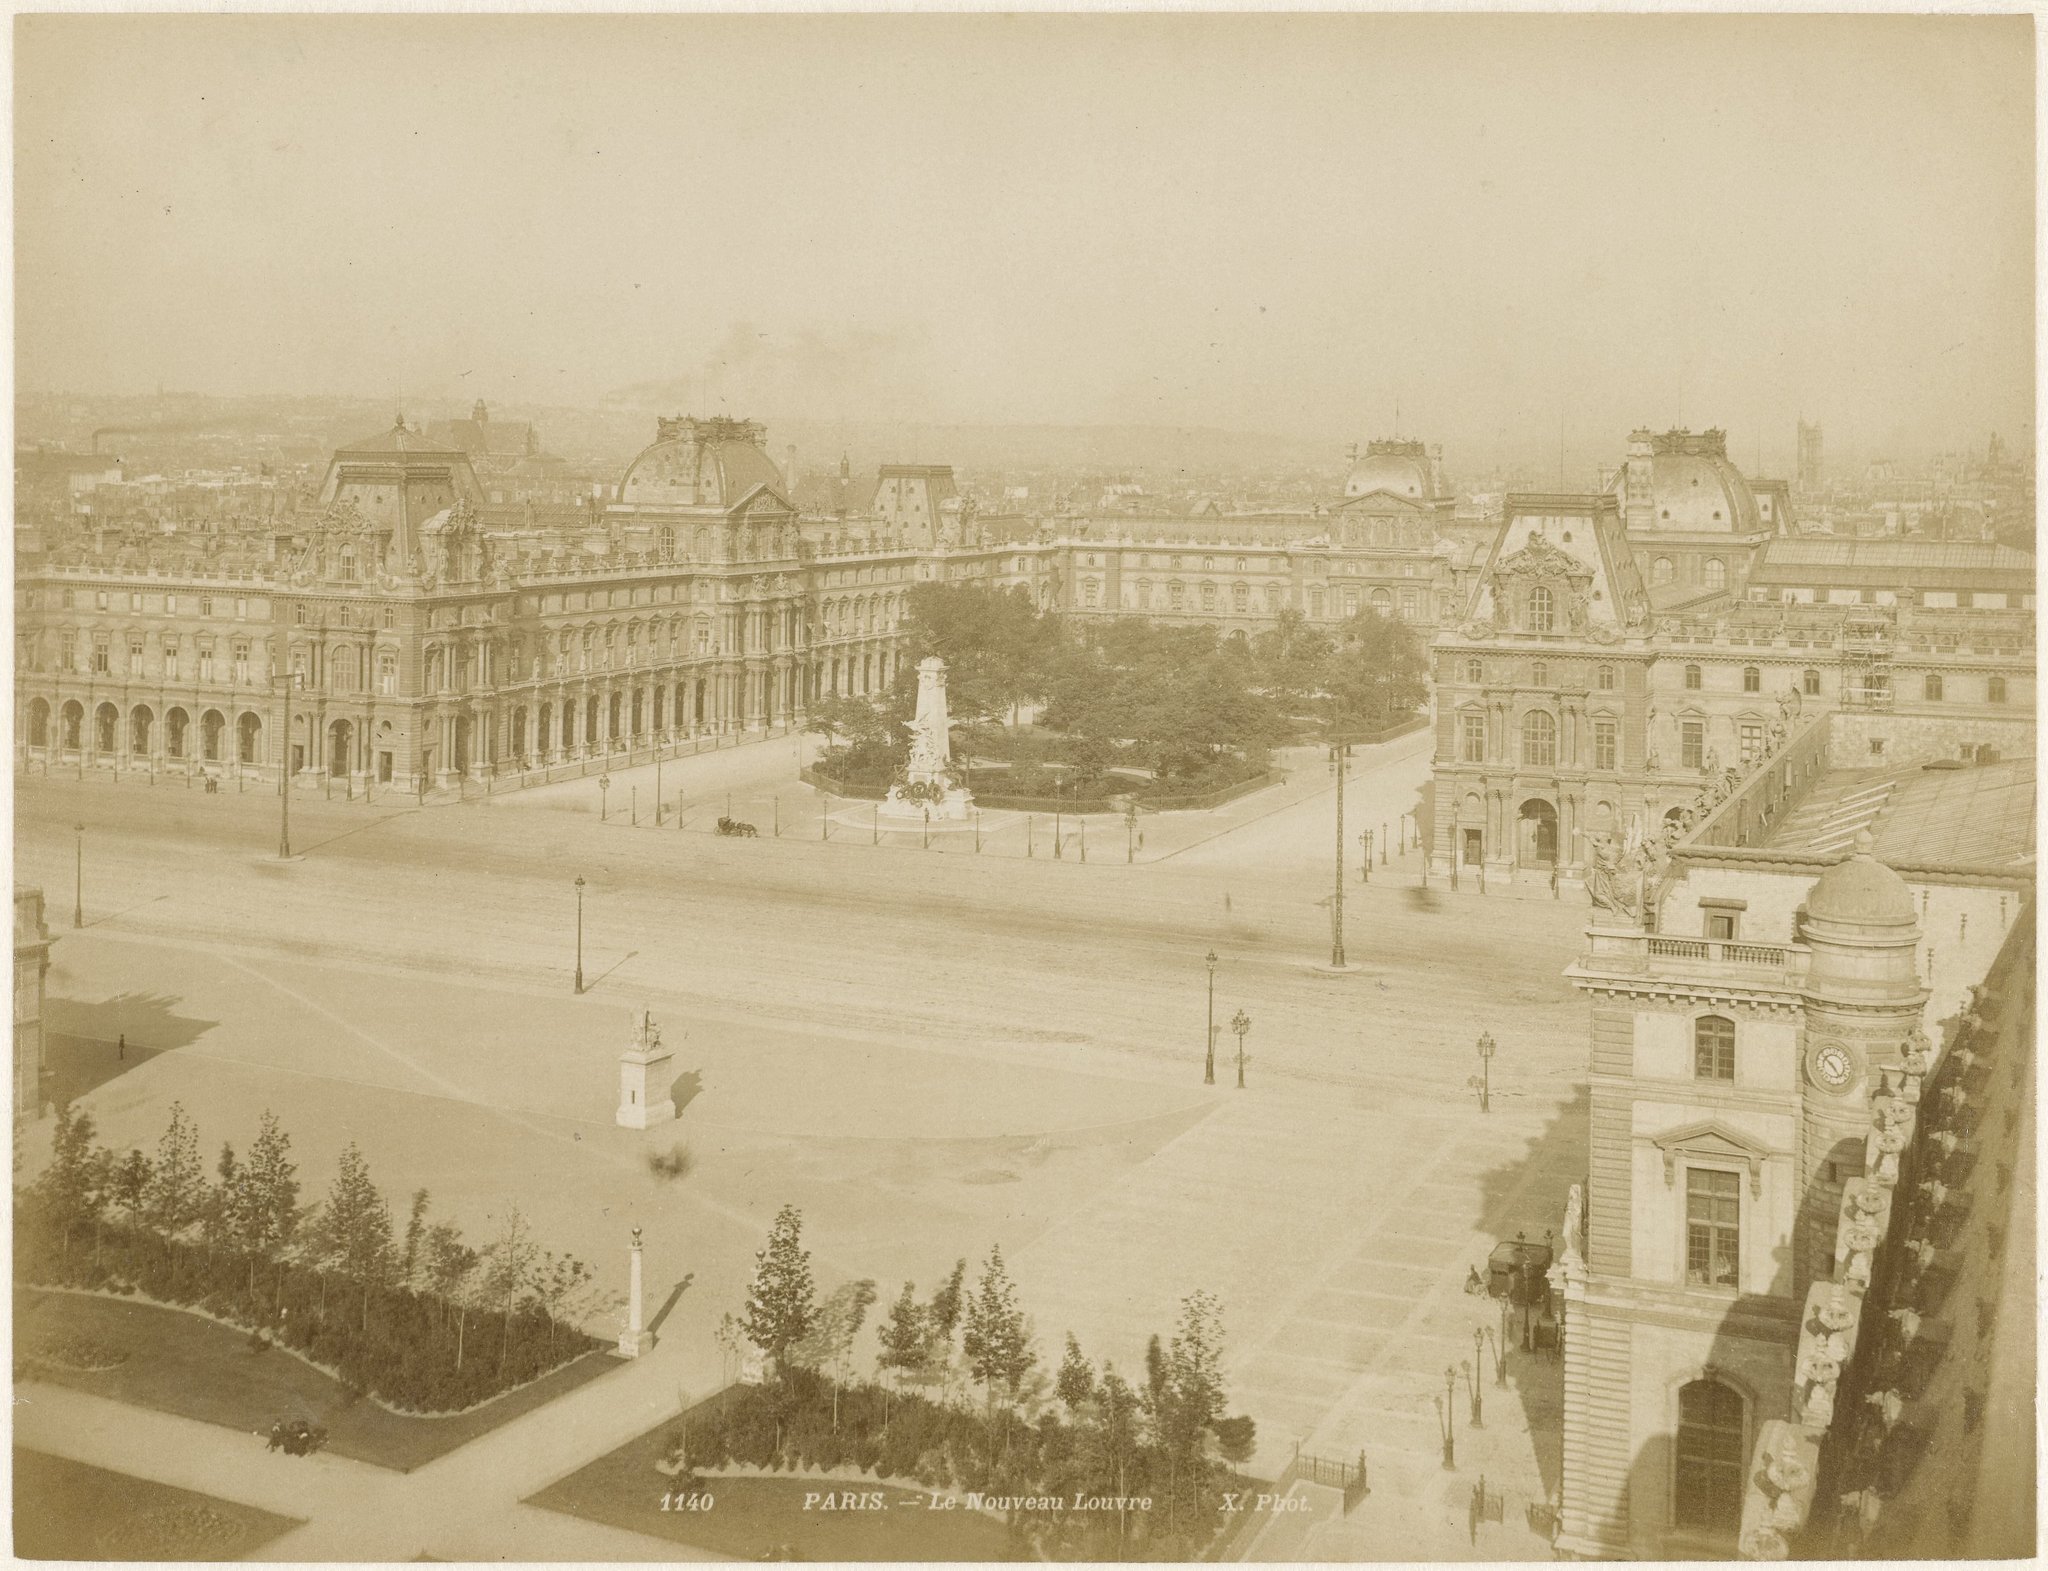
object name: photograph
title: Paris - Le Nouveau Louvre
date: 1887-1900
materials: paper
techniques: albumen print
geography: paris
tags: square, place, circus, etc., palace, permanent exhibition, museum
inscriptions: inscription: ‘1140 Paris. - Le Nouveau Louvre X. Phot.’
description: Tussen 1887 en ca. 1900 werkten Neurdein frères onder andere onder de naam 'X phot.'.